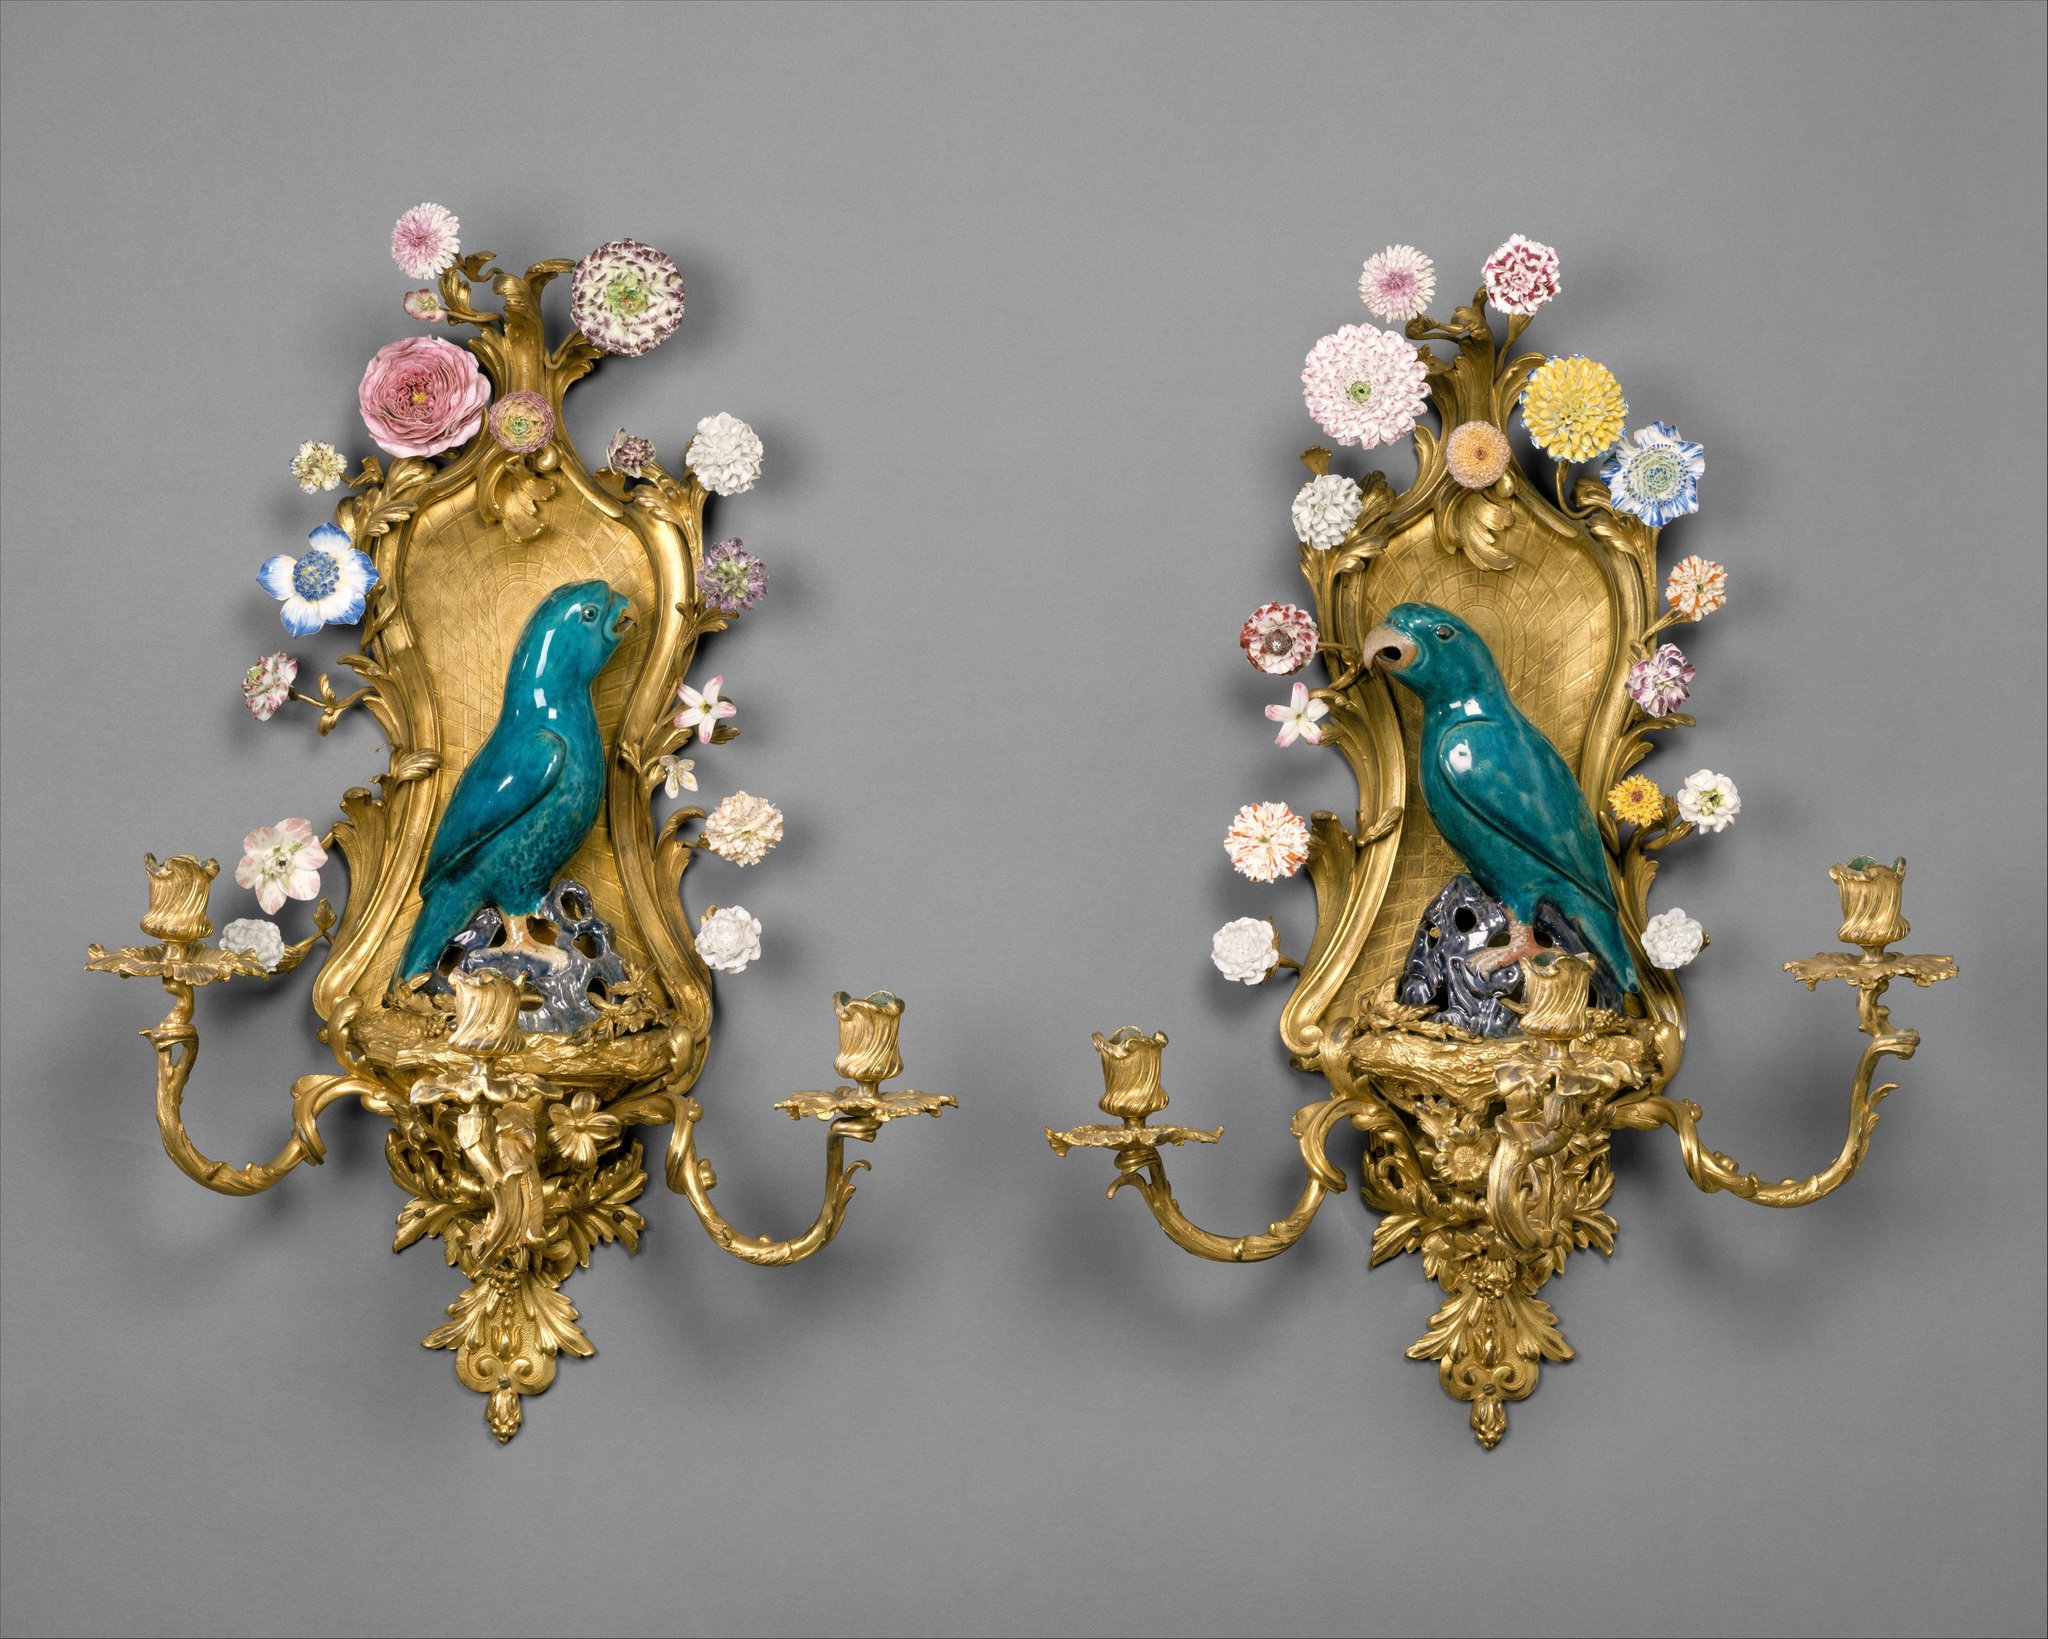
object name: wall light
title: Wall light (one of a pair)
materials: biscuit, gilt bronze, paste, porcelain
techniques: glazing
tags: parrots,flowers